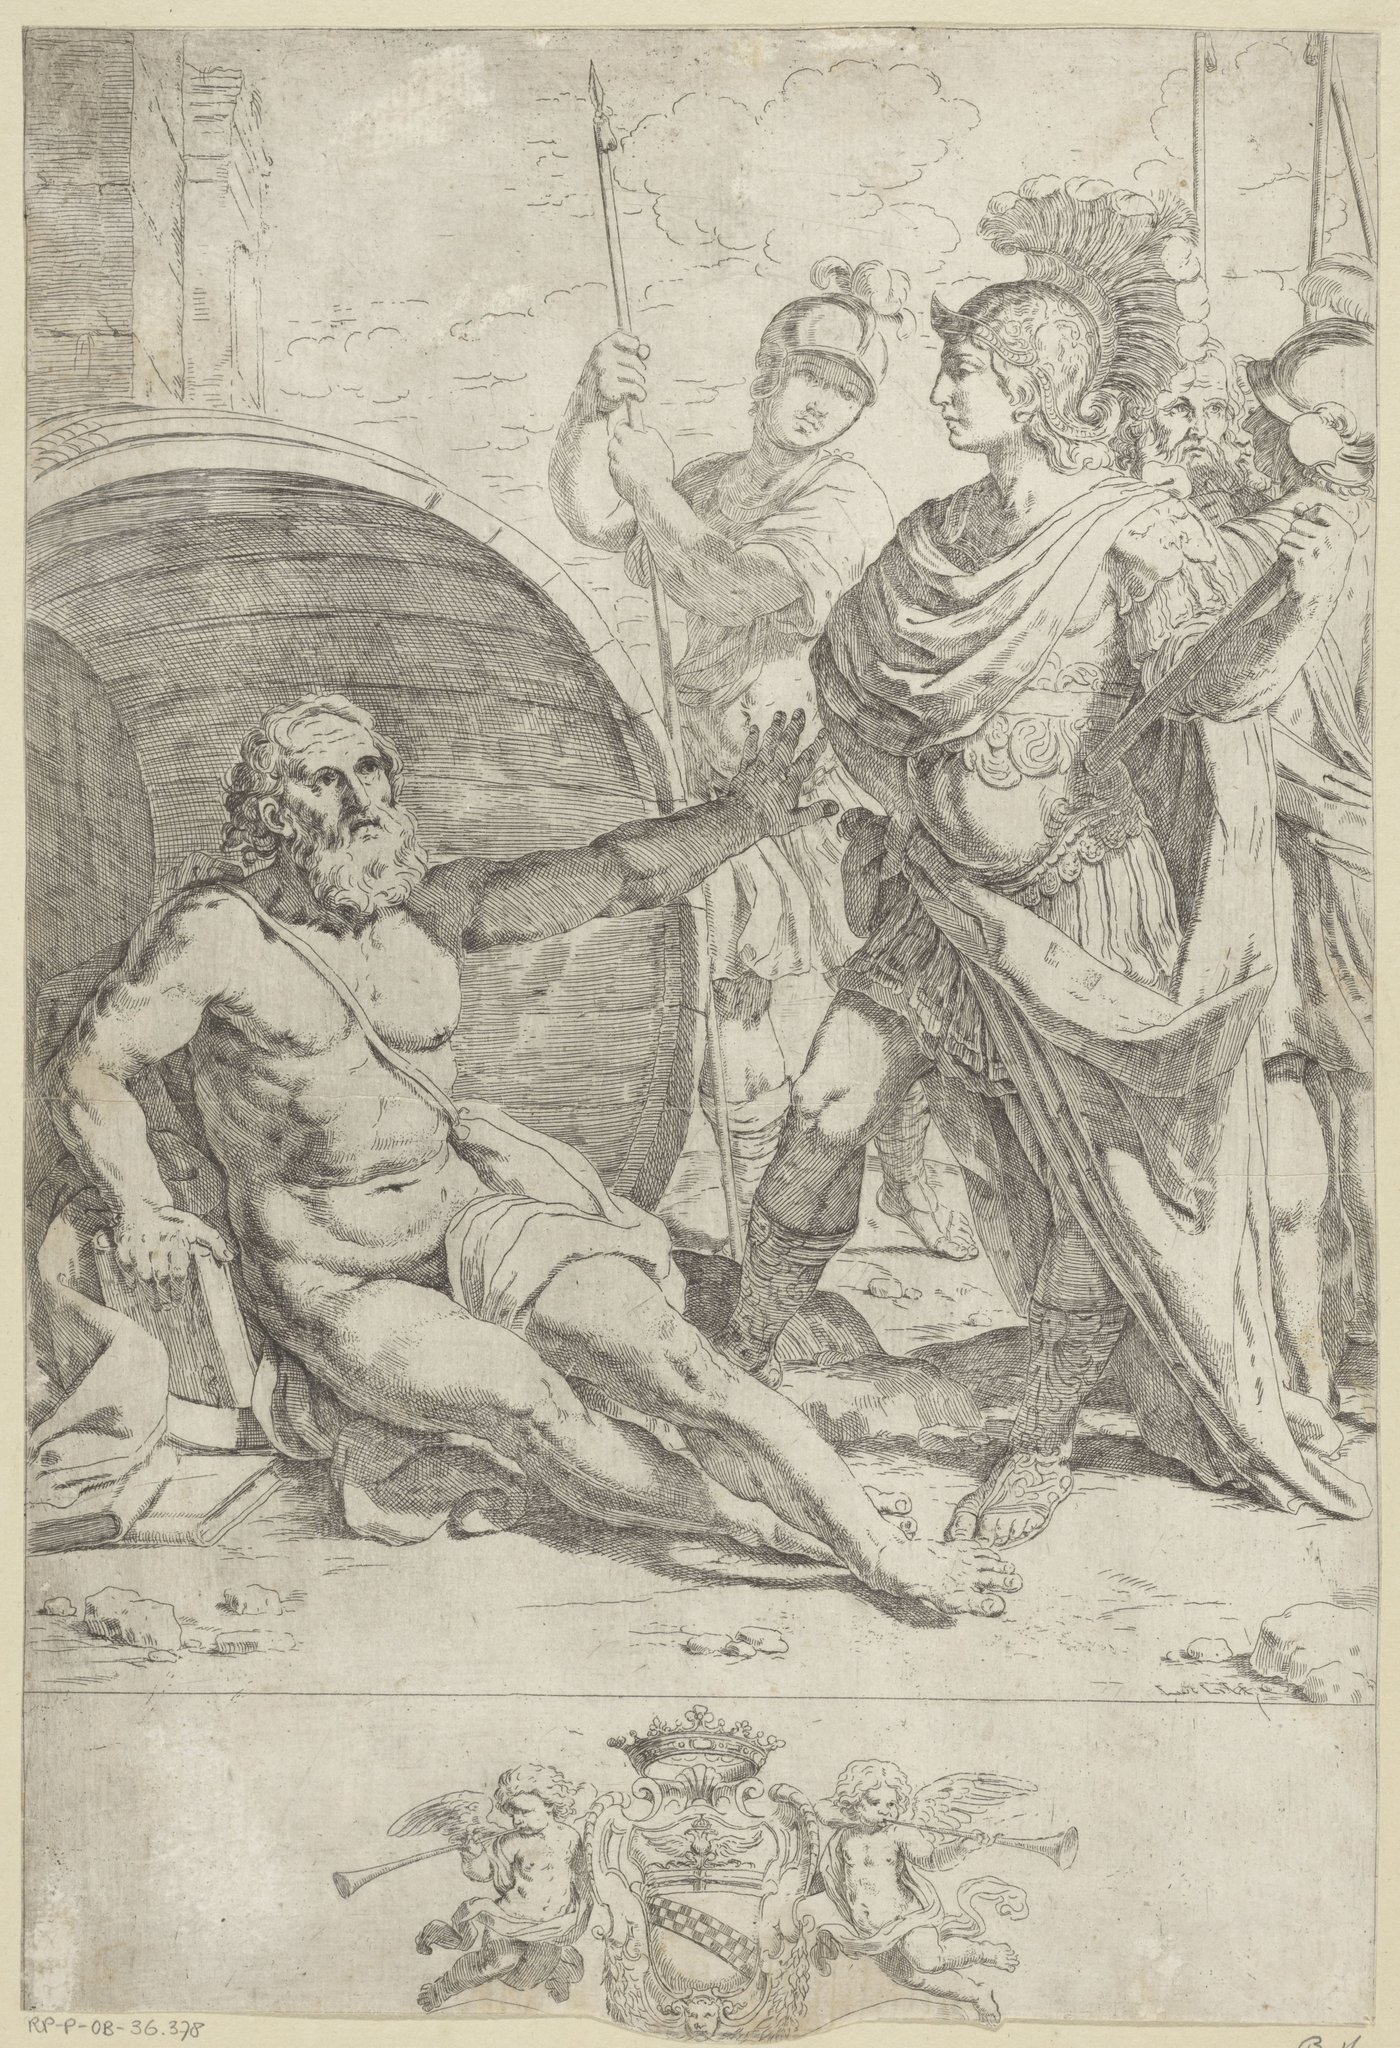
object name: print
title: Diogenes en Alexander de Grote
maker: lorenzo loli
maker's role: print maker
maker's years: 1612-1691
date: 1622-1691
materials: paper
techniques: etching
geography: italy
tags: alexander's visit to diogenes, who sits by his barrel and asks alexander to get out of his light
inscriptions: collector's mark: Lugt 240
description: De filosoof Diogenes zit voor zijn ton. Hij wenkt naar Alexander de Grote en zijn gevolg opzij te gaan, zodat hij niet langer in hun schaduw zit. Wapenschild in ondermarge.